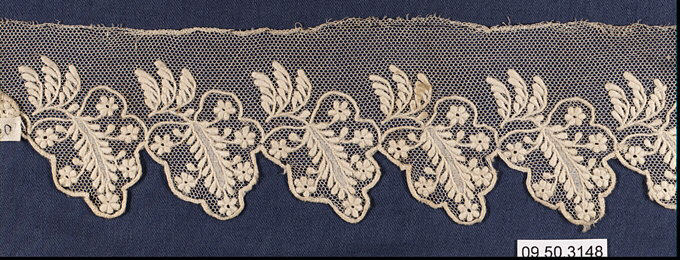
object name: edging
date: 1801-1900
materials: lace